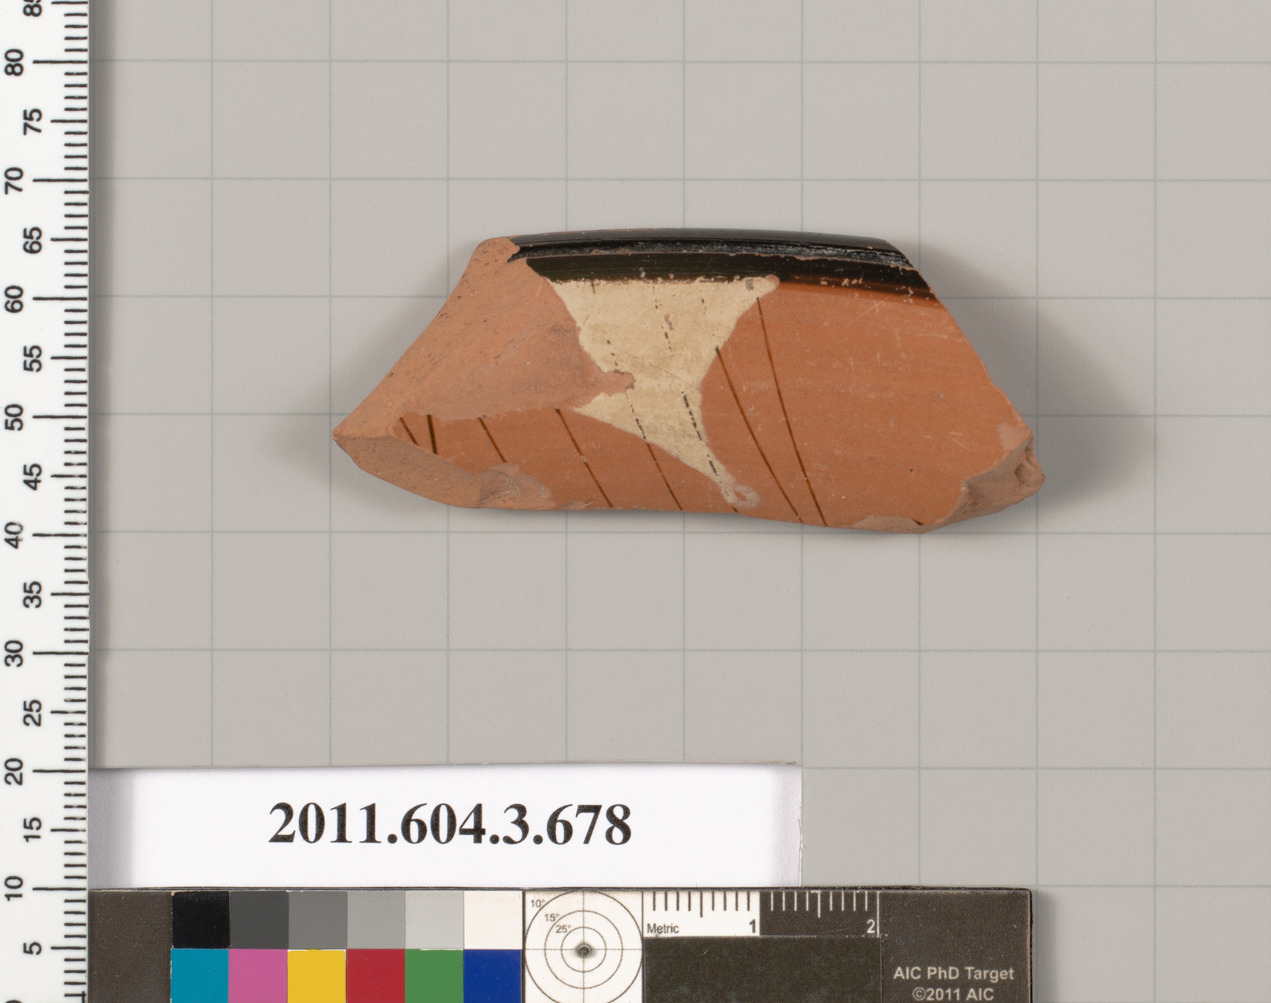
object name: stamnos fragment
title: Terracotta fragment of a stamnos (jar)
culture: greek, attic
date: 510-500 BCE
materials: terracotta